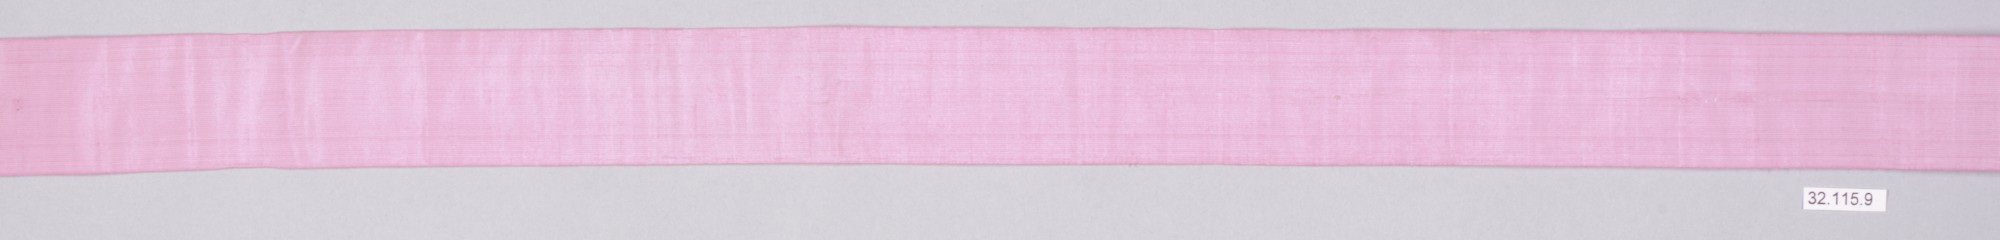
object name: ribbon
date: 1860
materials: silk